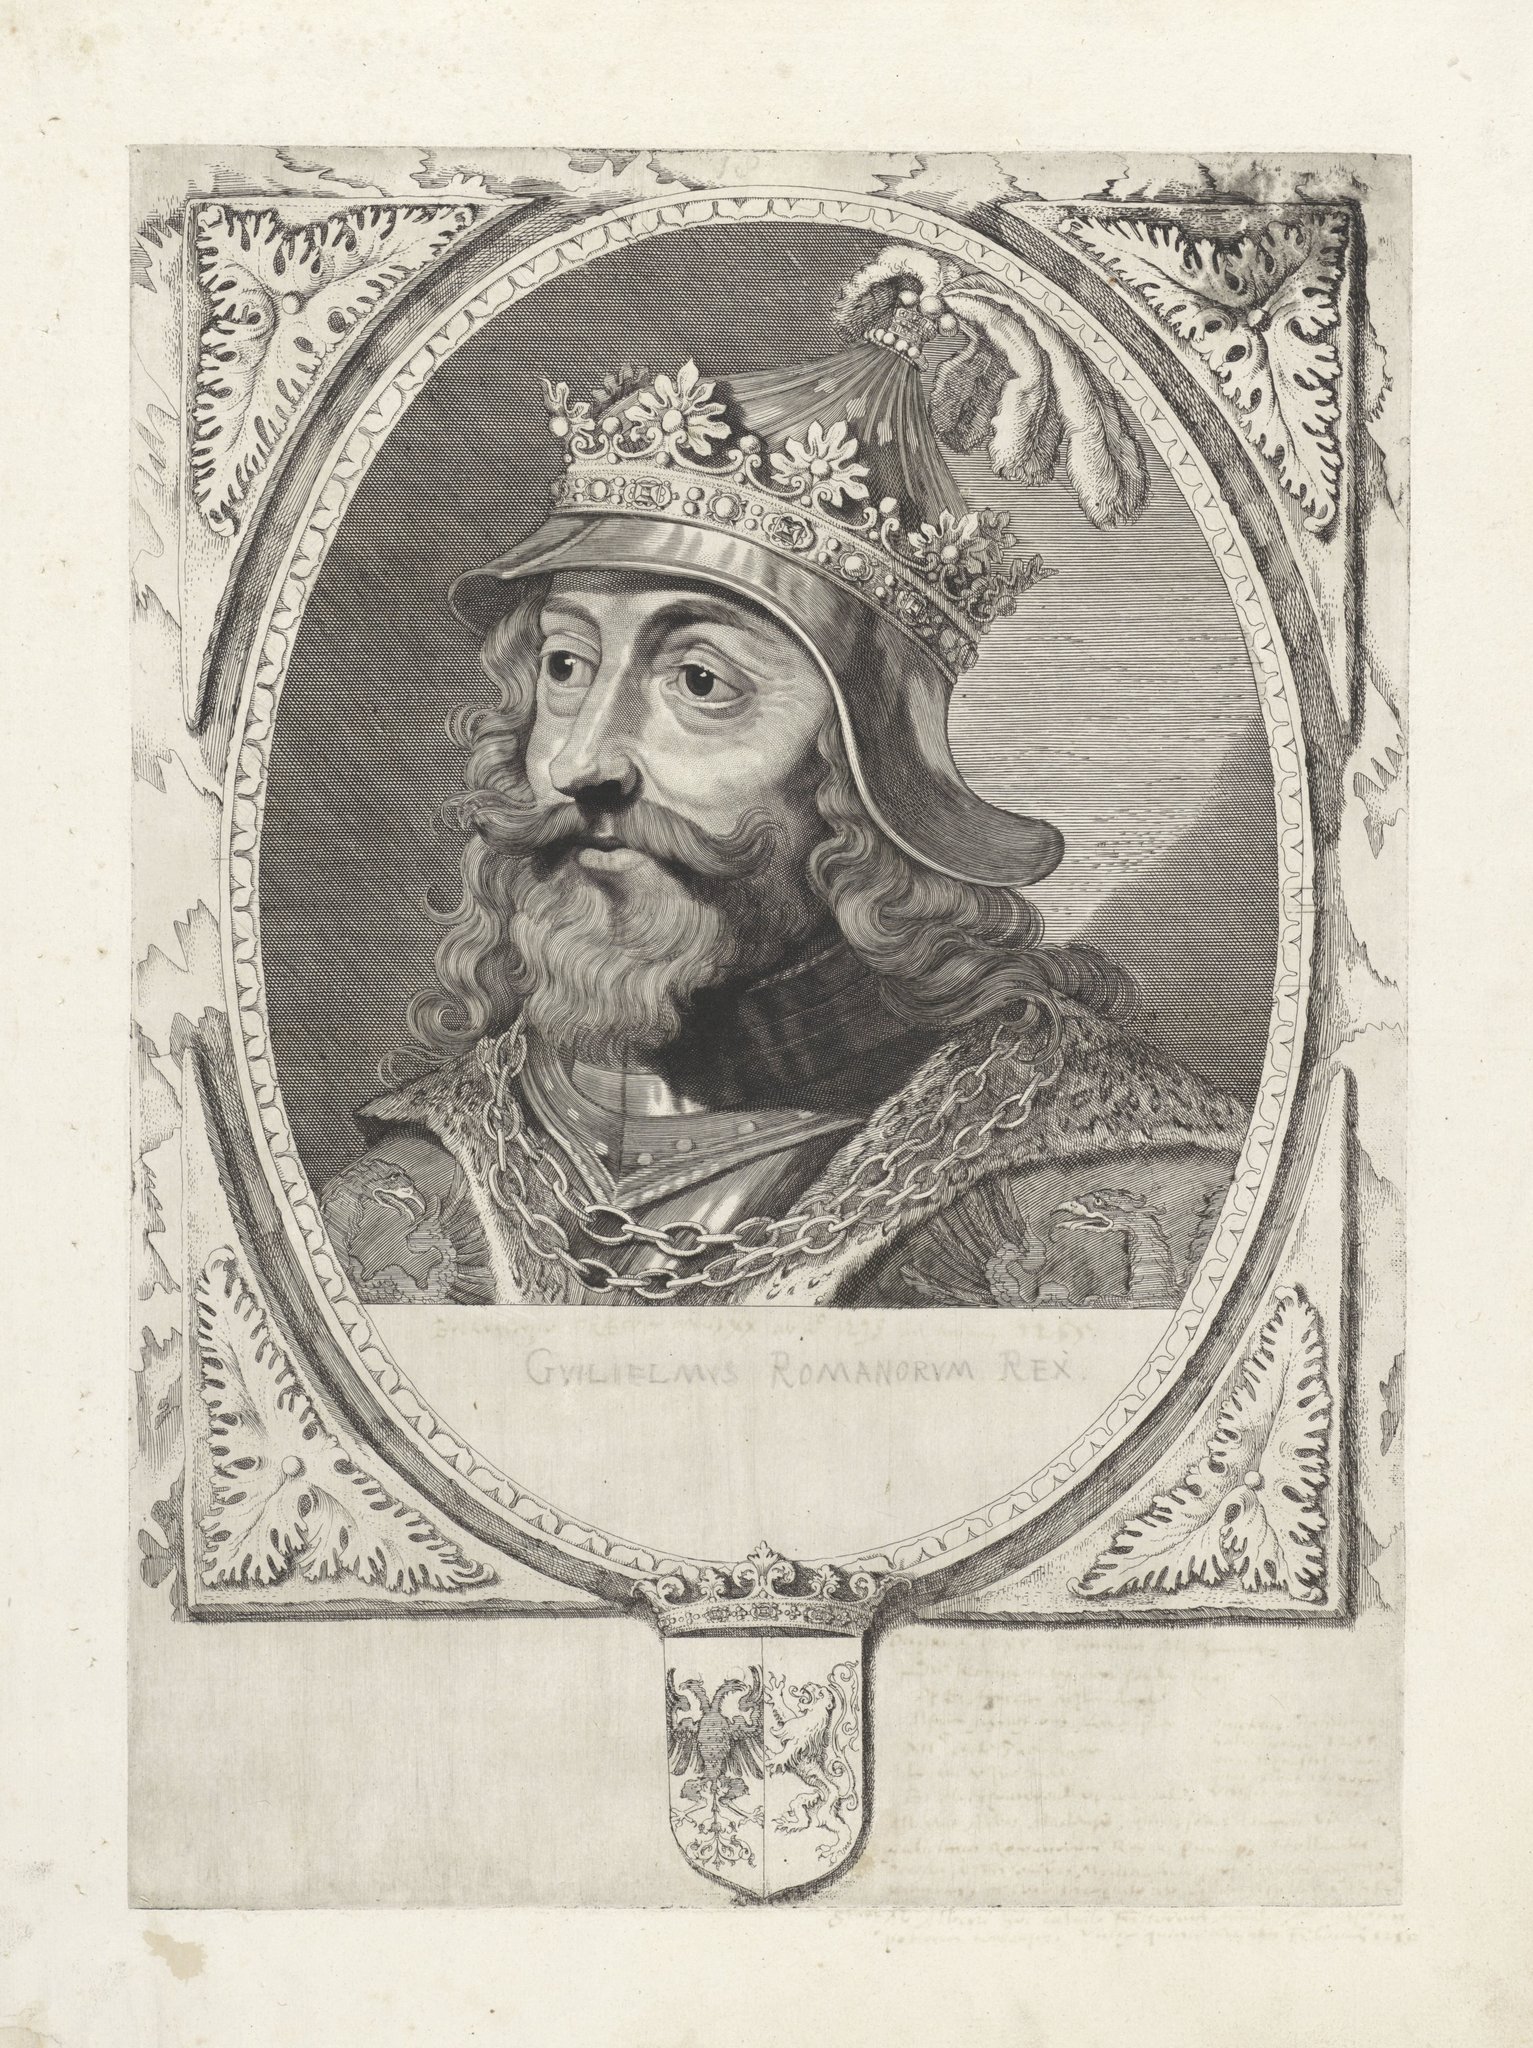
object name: print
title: Portret van Willem II, graaf van Holland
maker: cornelis visscher (ii)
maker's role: draughtsman, painter, print maker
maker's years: 1628-1658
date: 1650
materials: paper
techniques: engraving, etching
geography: haarlem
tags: earl, helmet, crown (symbol of sovereignty), armour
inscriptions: collector's mark: Lugt 240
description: Willem II, graaf van Holland en rooms-koning. Hij draagt een harnas en een mantel en heeft op het hoofd een helm met een kroon. De omlijsting is versierd met een wapen met een leeuw en een adelaar.